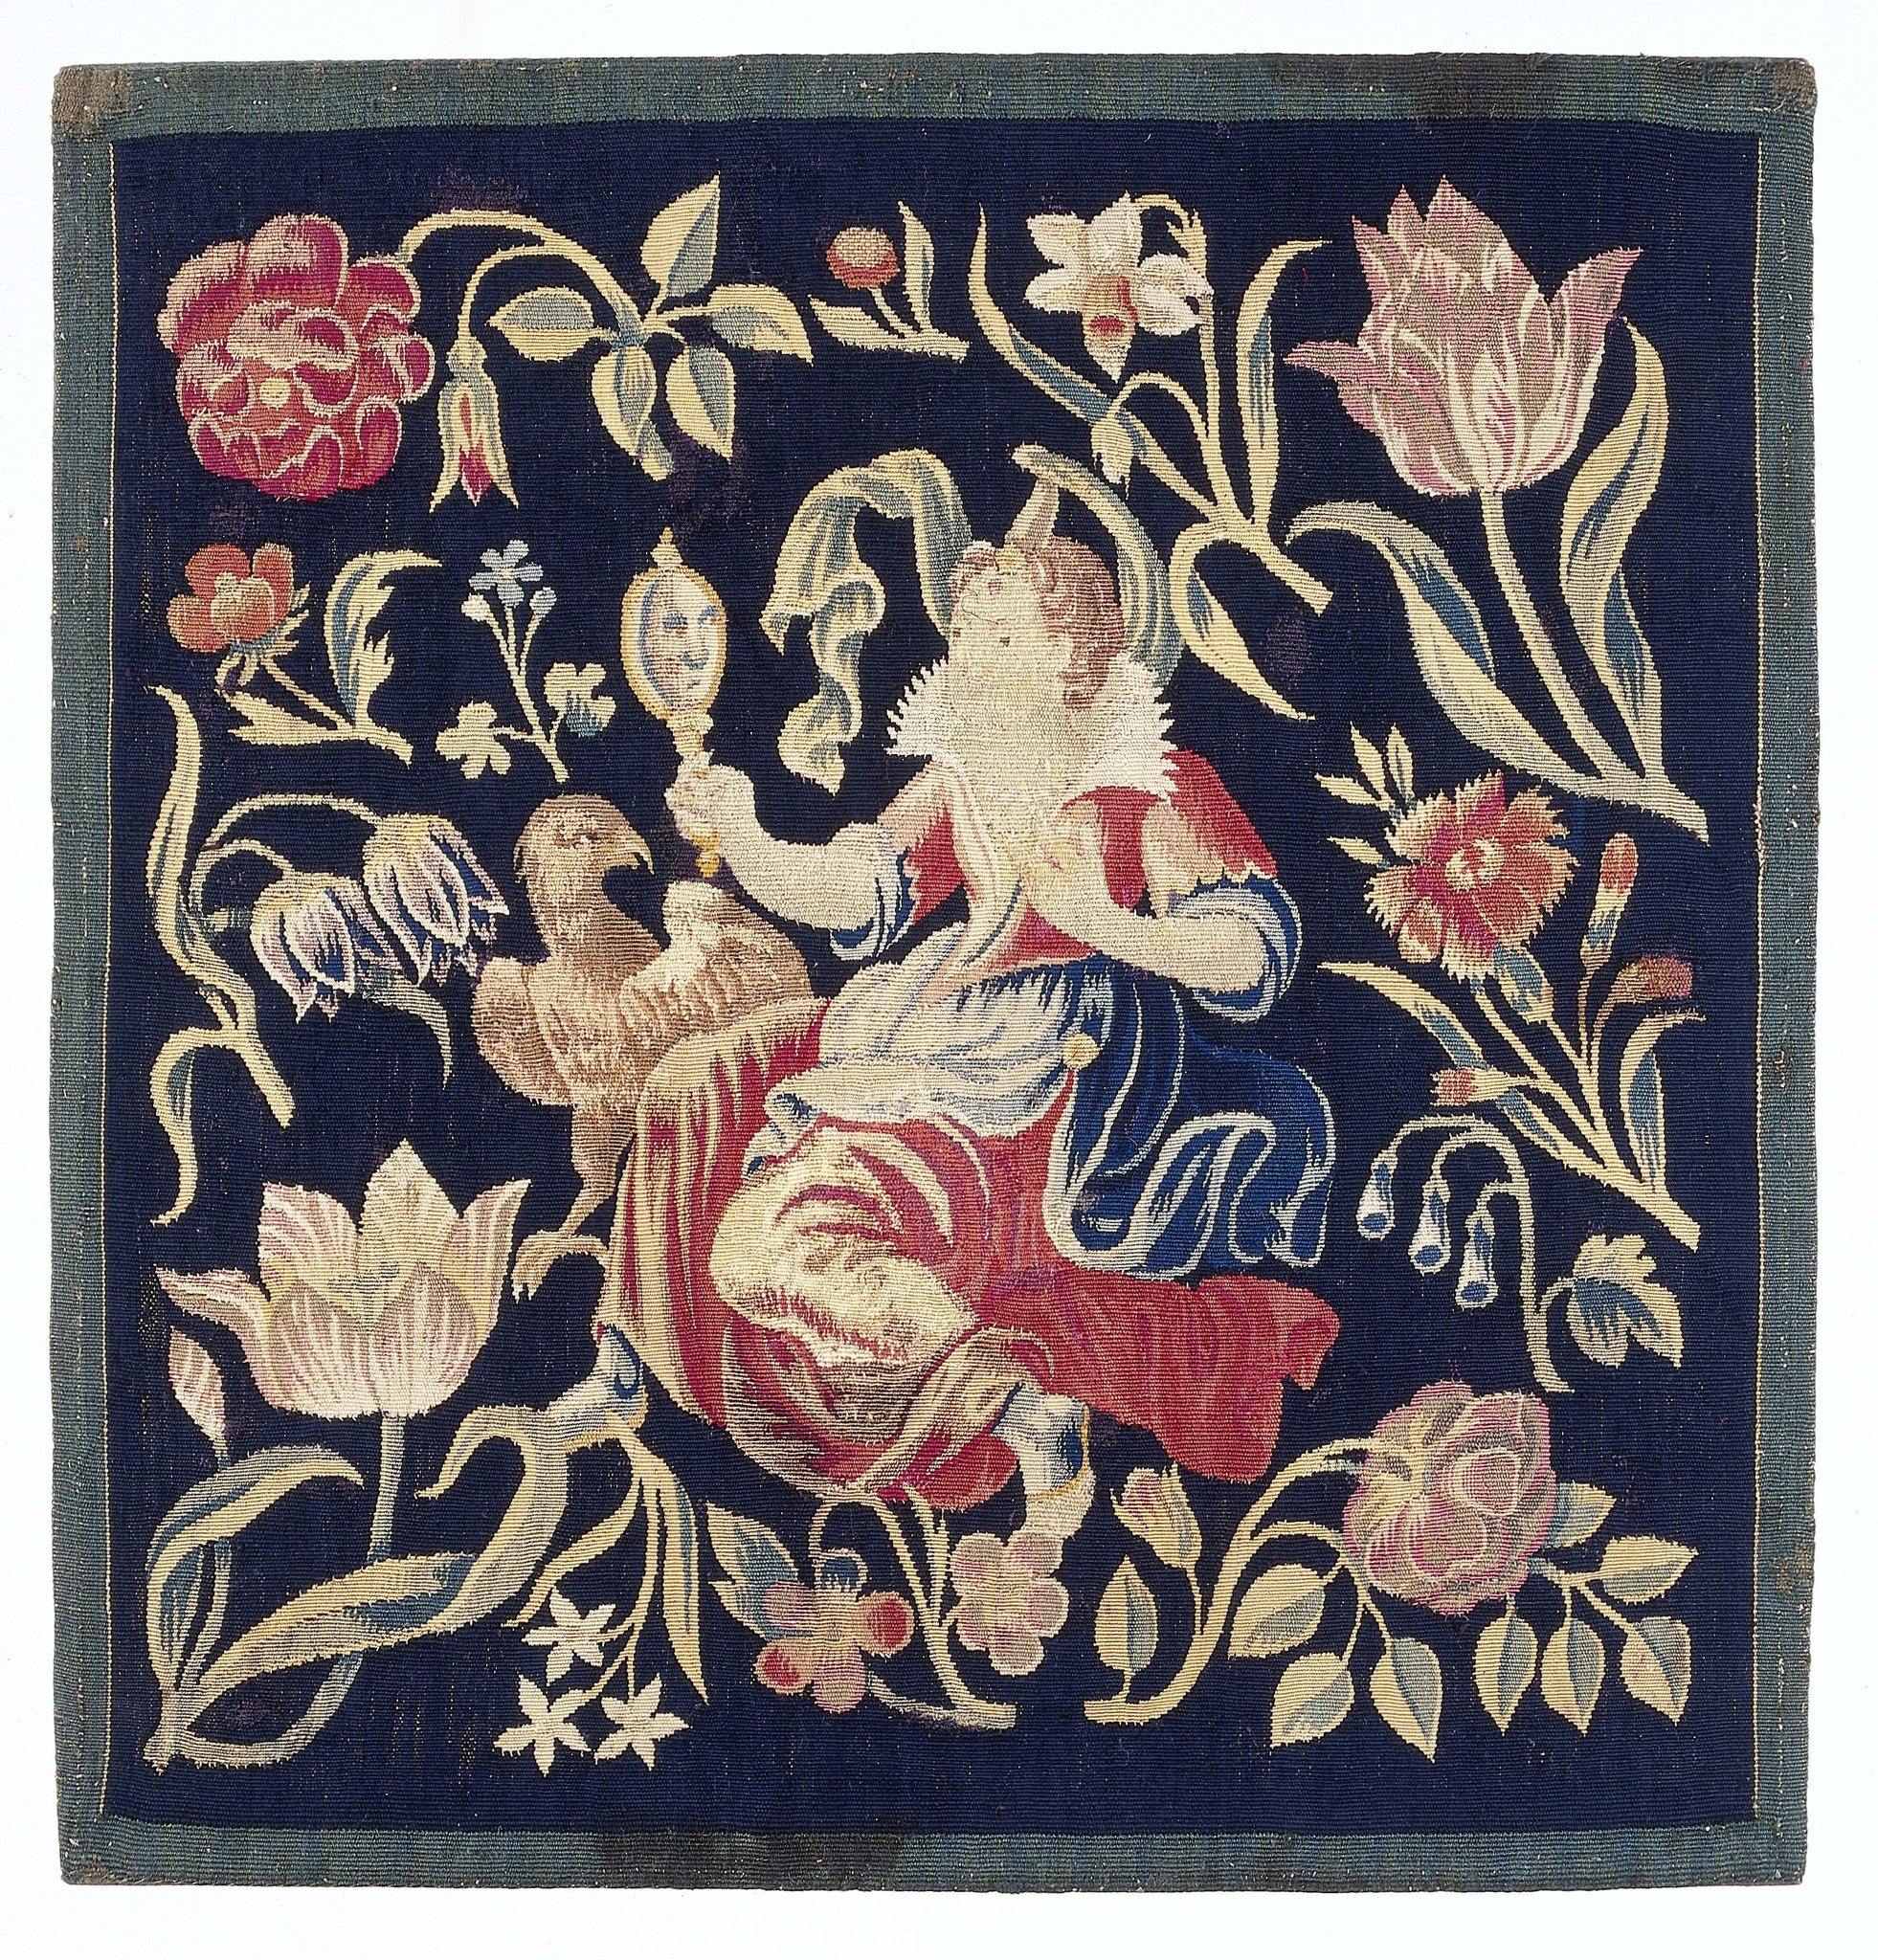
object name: pillow sham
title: Kussenovertrek met de personificatie van het gezicht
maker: Anonymous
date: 1650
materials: silk, wool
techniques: tapestry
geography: northern netherlands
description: Kussenovertek van tapisserie met een der vijf zinnen, het gezicht. Op een donkerblauw vierkant is een vrouwenfiguur gezeten door grote bloemen omgeven, naar links kijkend in een opgeheven spiegel en vergezeld van een adelaar. Rondom staan grote gestrooide bloemen.